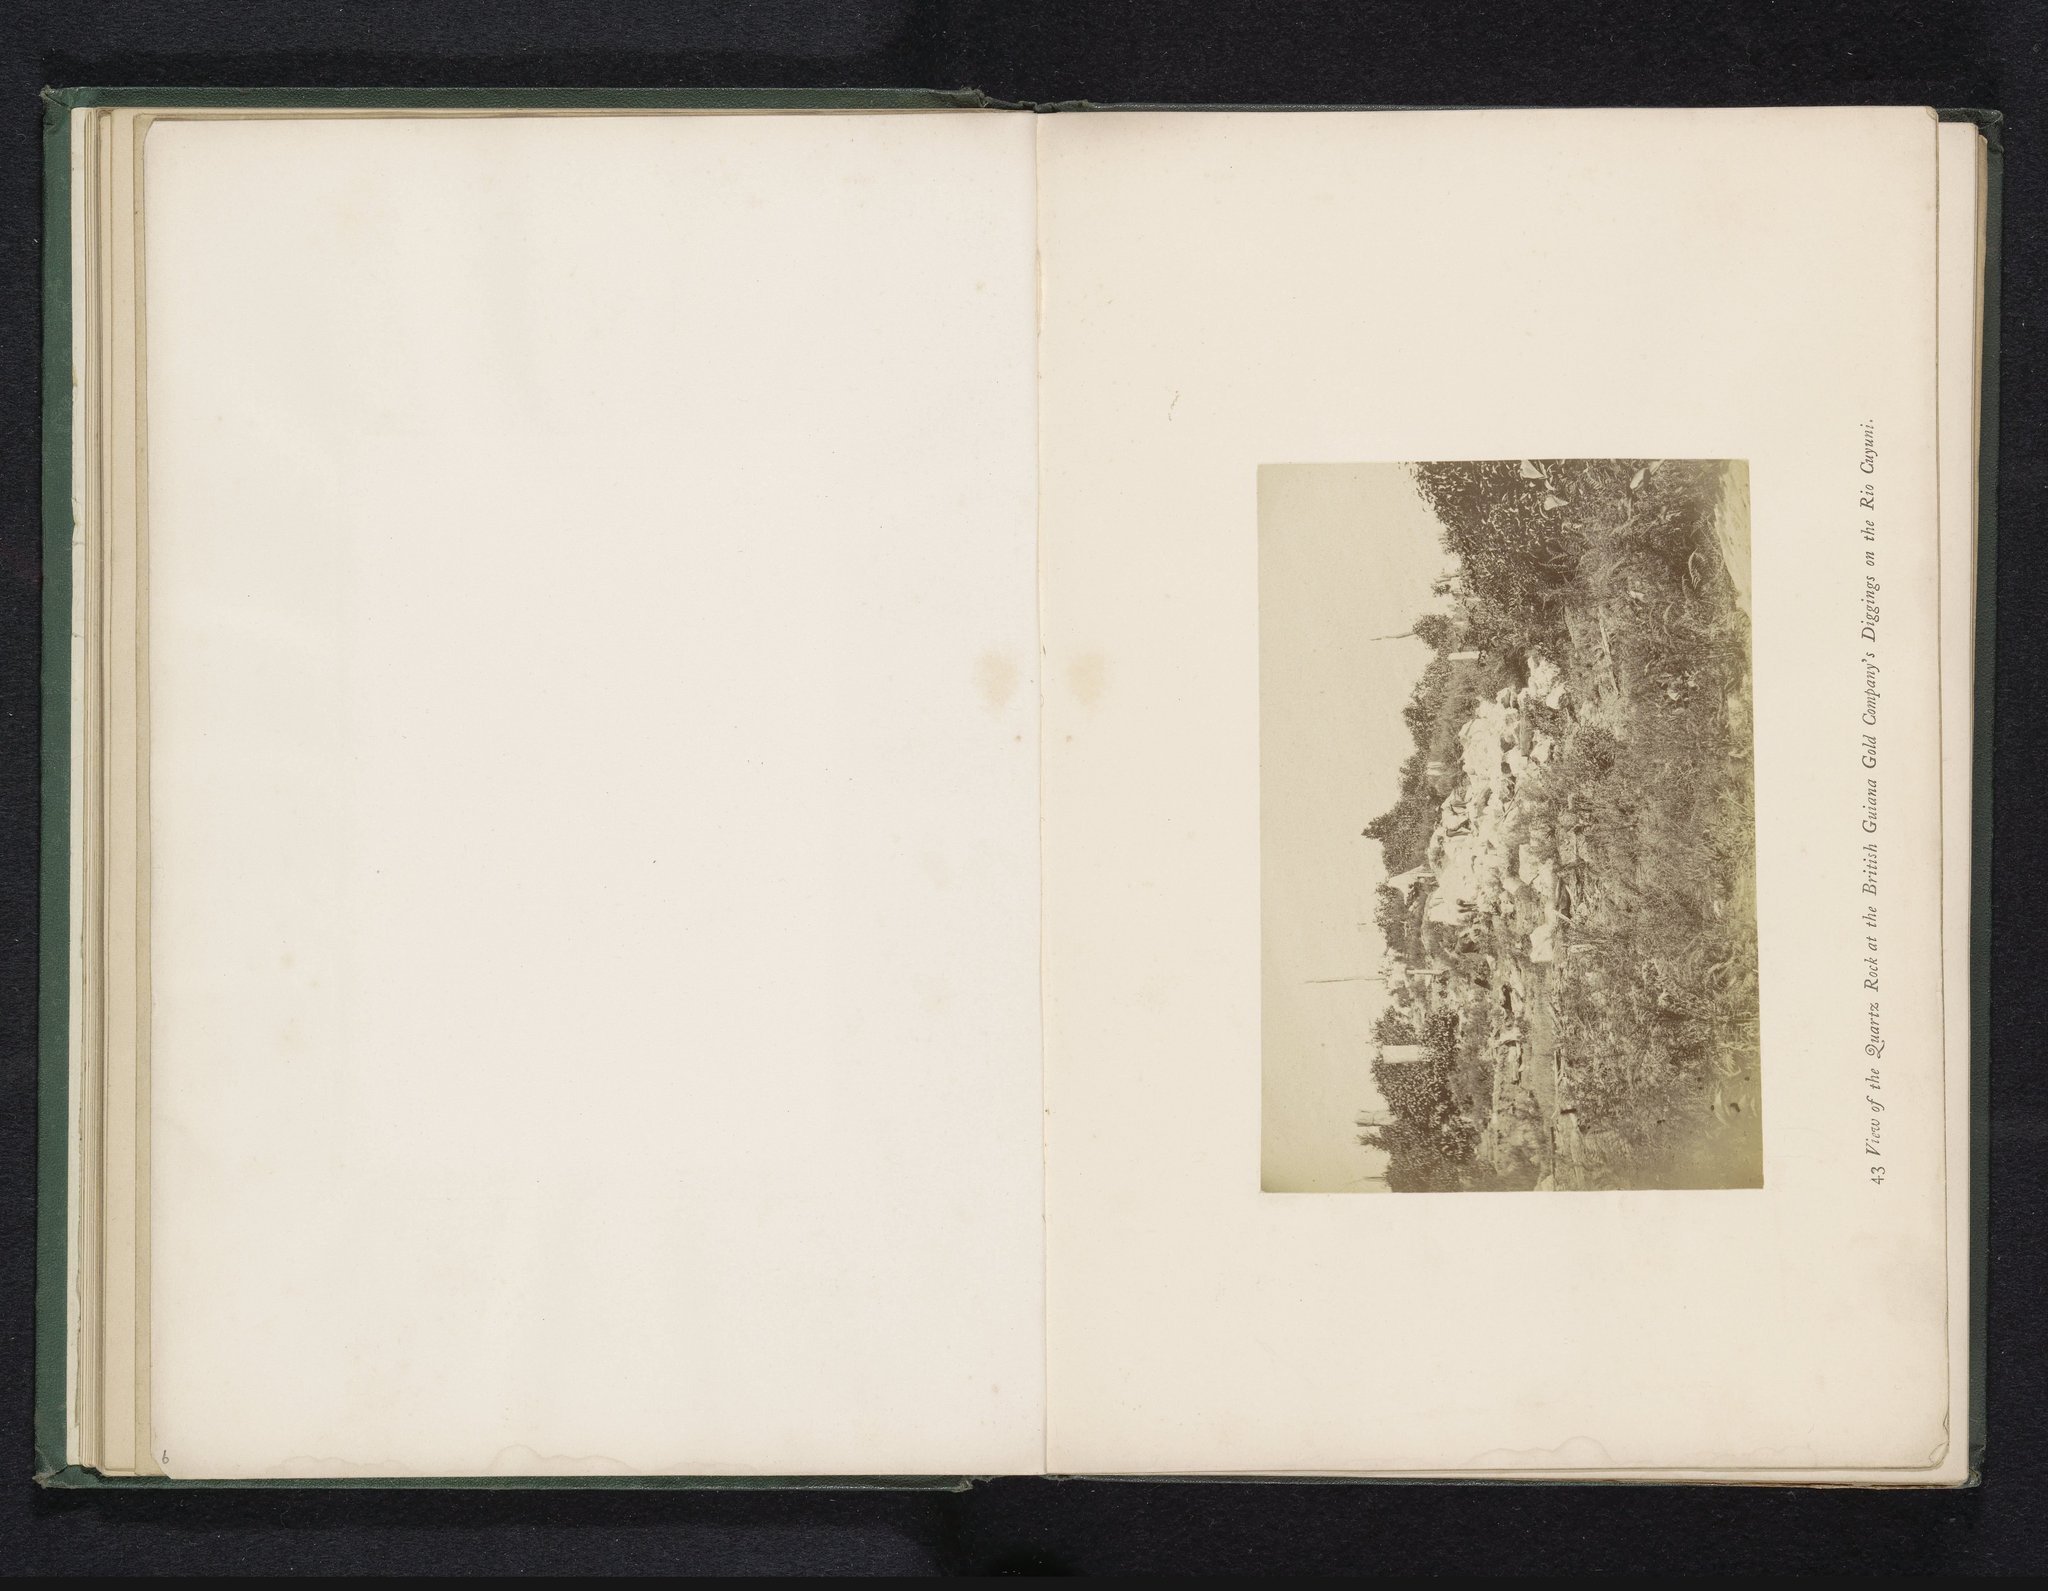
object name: photograph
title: Rots met kwarts bij een bedrijf voor goudwinning aan de Cuyuni rivier in Guyana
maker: Anonymous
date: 1856-1866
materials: photographic support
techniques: albumen print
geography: guyana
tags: minerals and metals: gold, rock-formations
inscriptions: number: ‘43’